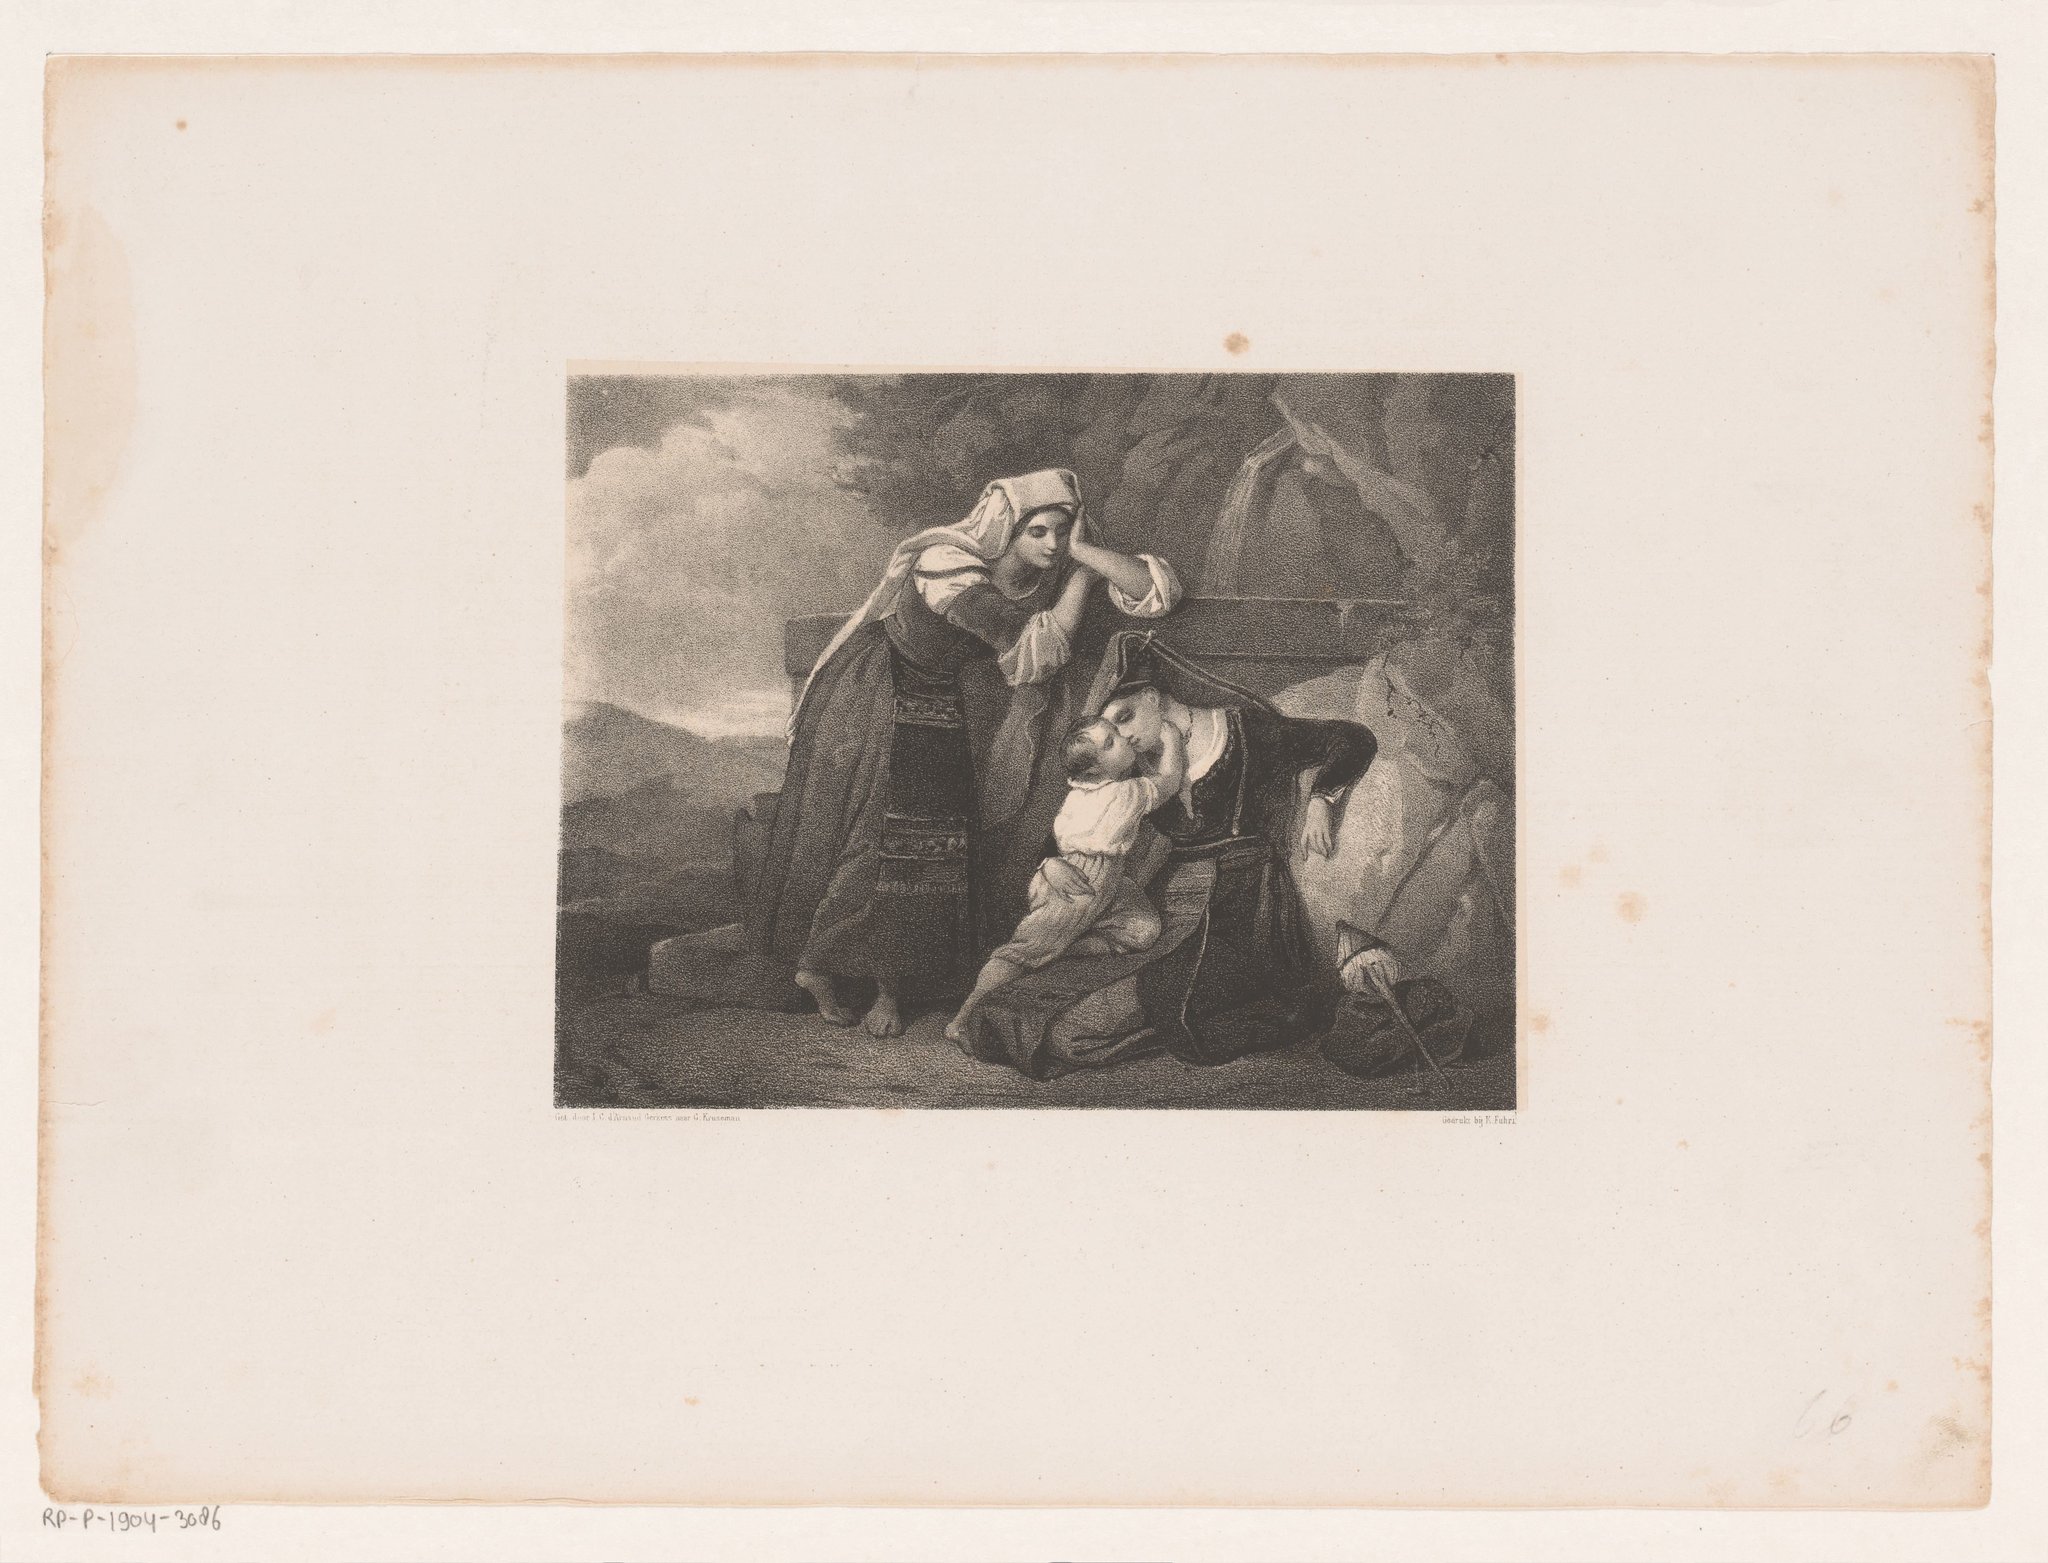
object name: print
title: Italiaanse vrouwen en een kind bij een bron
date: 1837-1855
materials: paper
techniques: tone lithography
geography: the hague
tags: well, embracing each other, kissing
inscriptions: collector's mark: Lugt 2228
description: Een van de vrouwen zit op de grond en wordt omhelst door de jongen. De andere vrouw leunt op de rand van de put. Het water komt uit de rotswand.